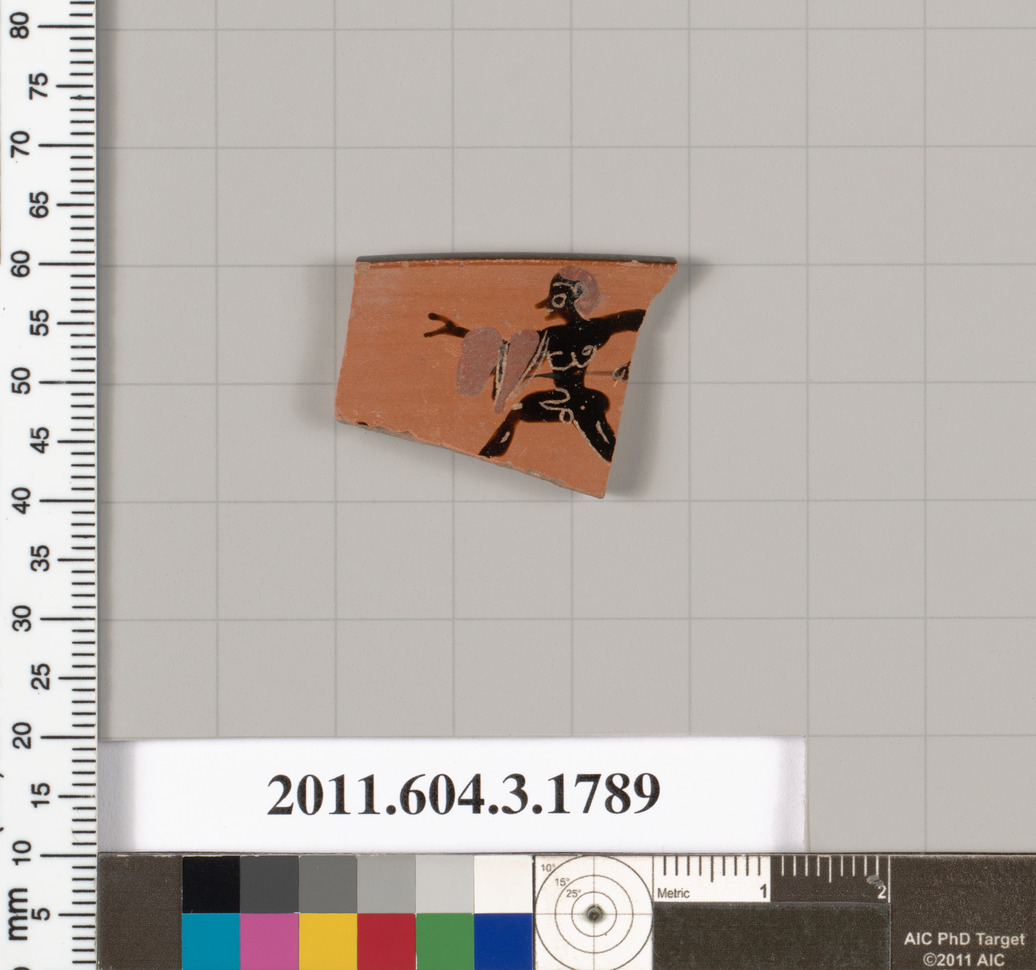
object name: kylix fragment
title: Terracotta rim fragment of a kylix: Lip cup (drinking cup)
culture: greek, attic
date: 560-550 BCE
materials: terracotta